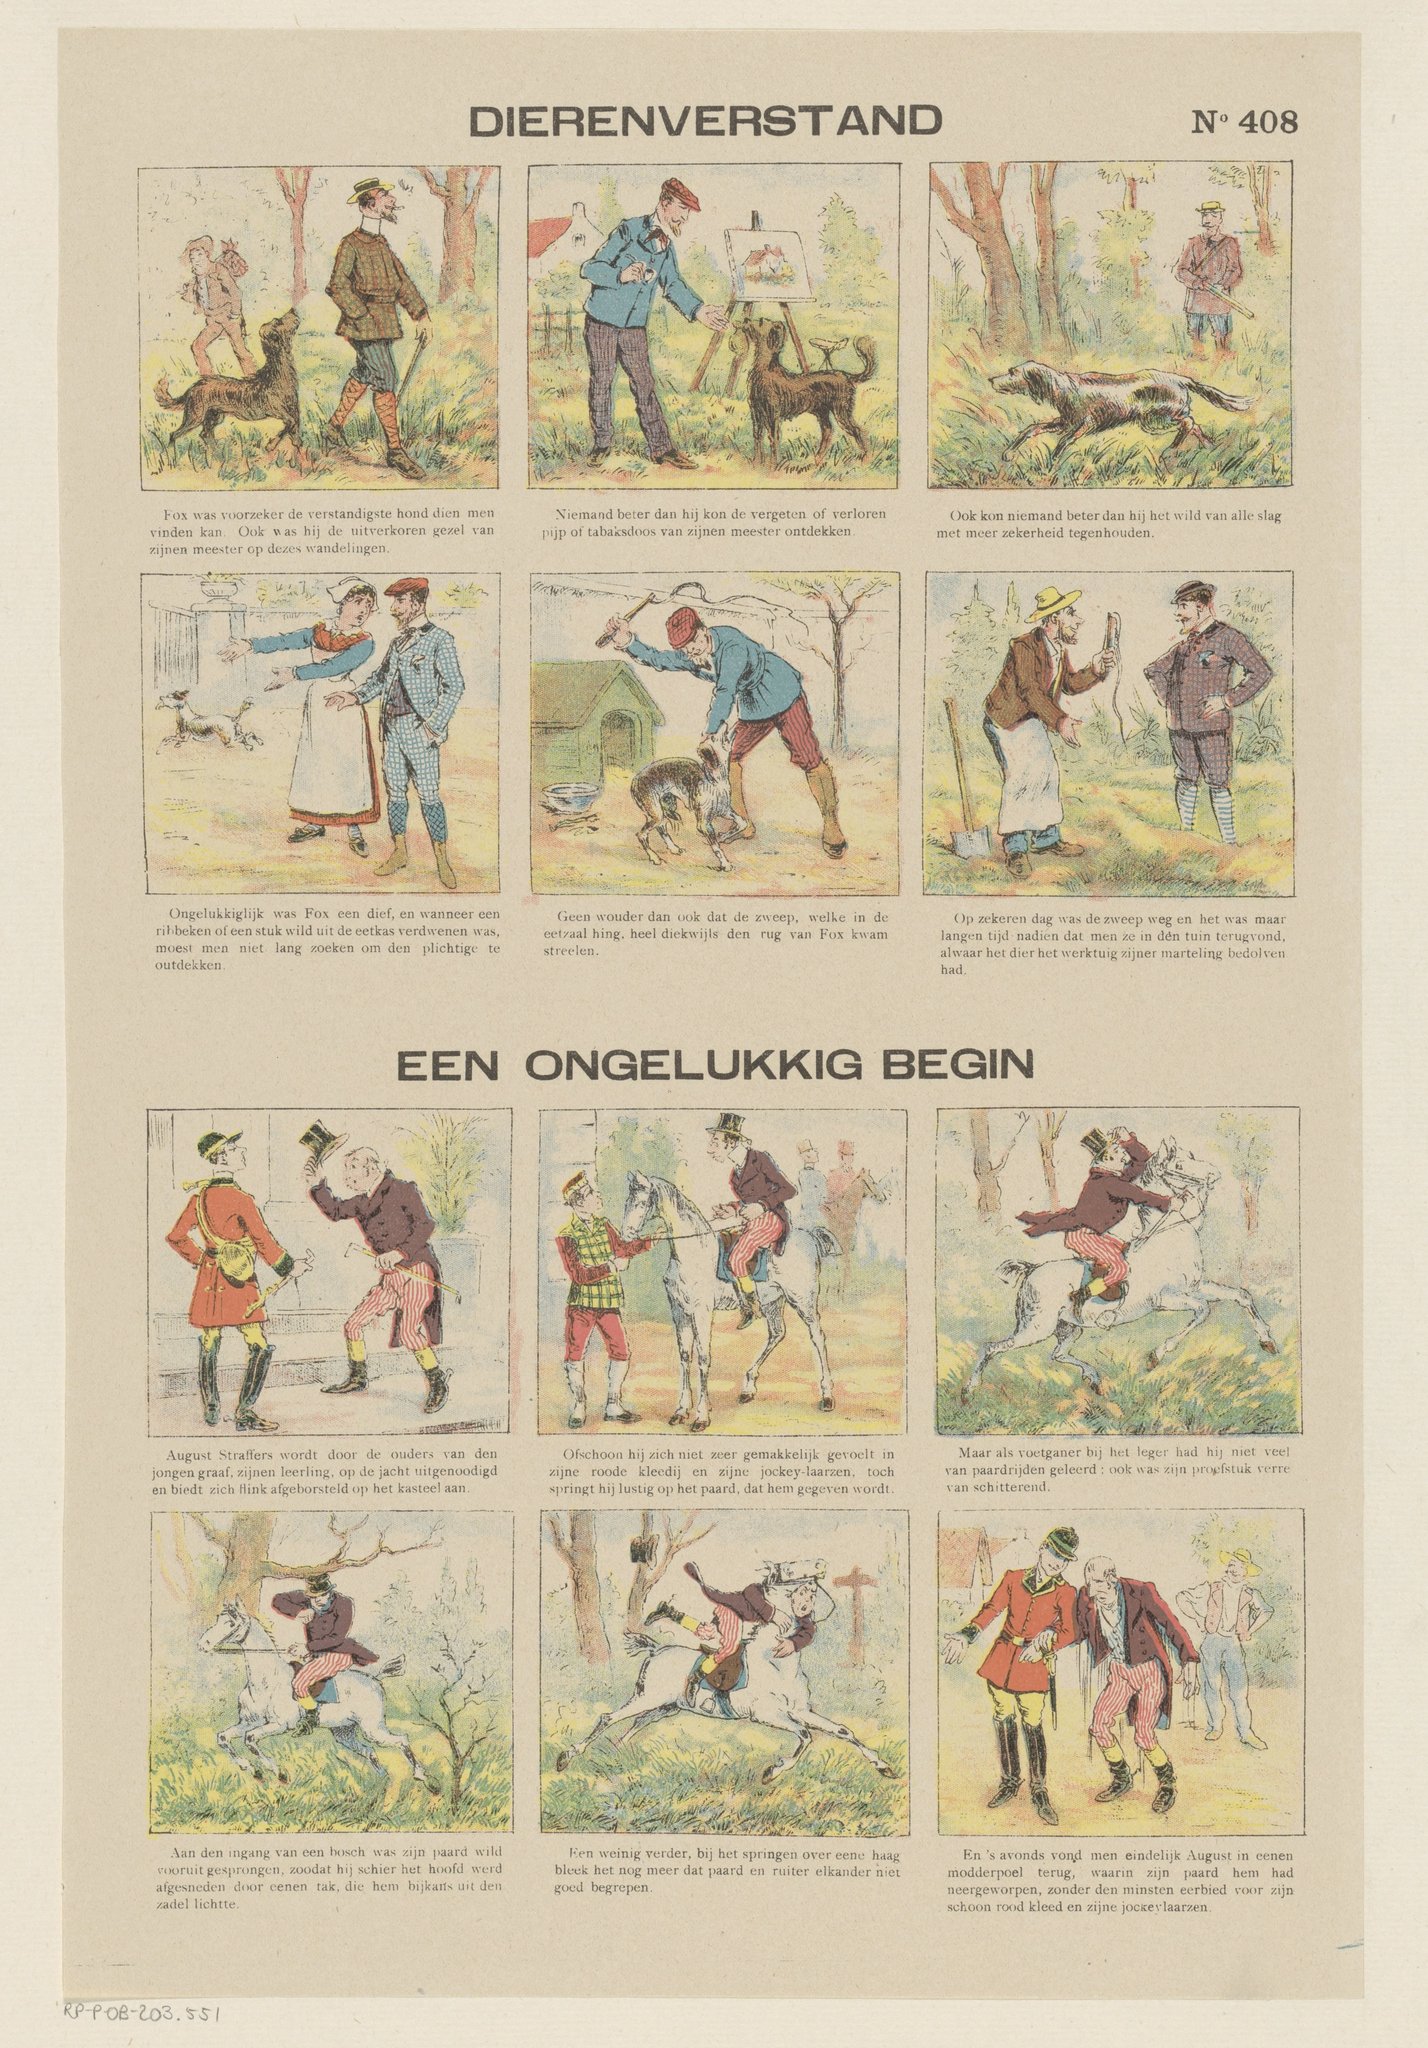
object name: popular print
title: Dierenverstand / Een ongelukkig begin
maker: Anonymous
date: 1894-1959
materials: paper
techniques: lithograph, letterpress printing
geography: liège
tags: riding a horse, ass, or mule; rider, horseman, dog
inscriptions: collector's mark: Lugt 2760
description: Blad met 12 voorstellingen. Boven zes voorstellingen over een slimme hond. Onder zes voorstellingen over een man die slecht kan paardrijden. Onder elke afbeelding een onderschrift. Genummerd rechtsboven: No 408.